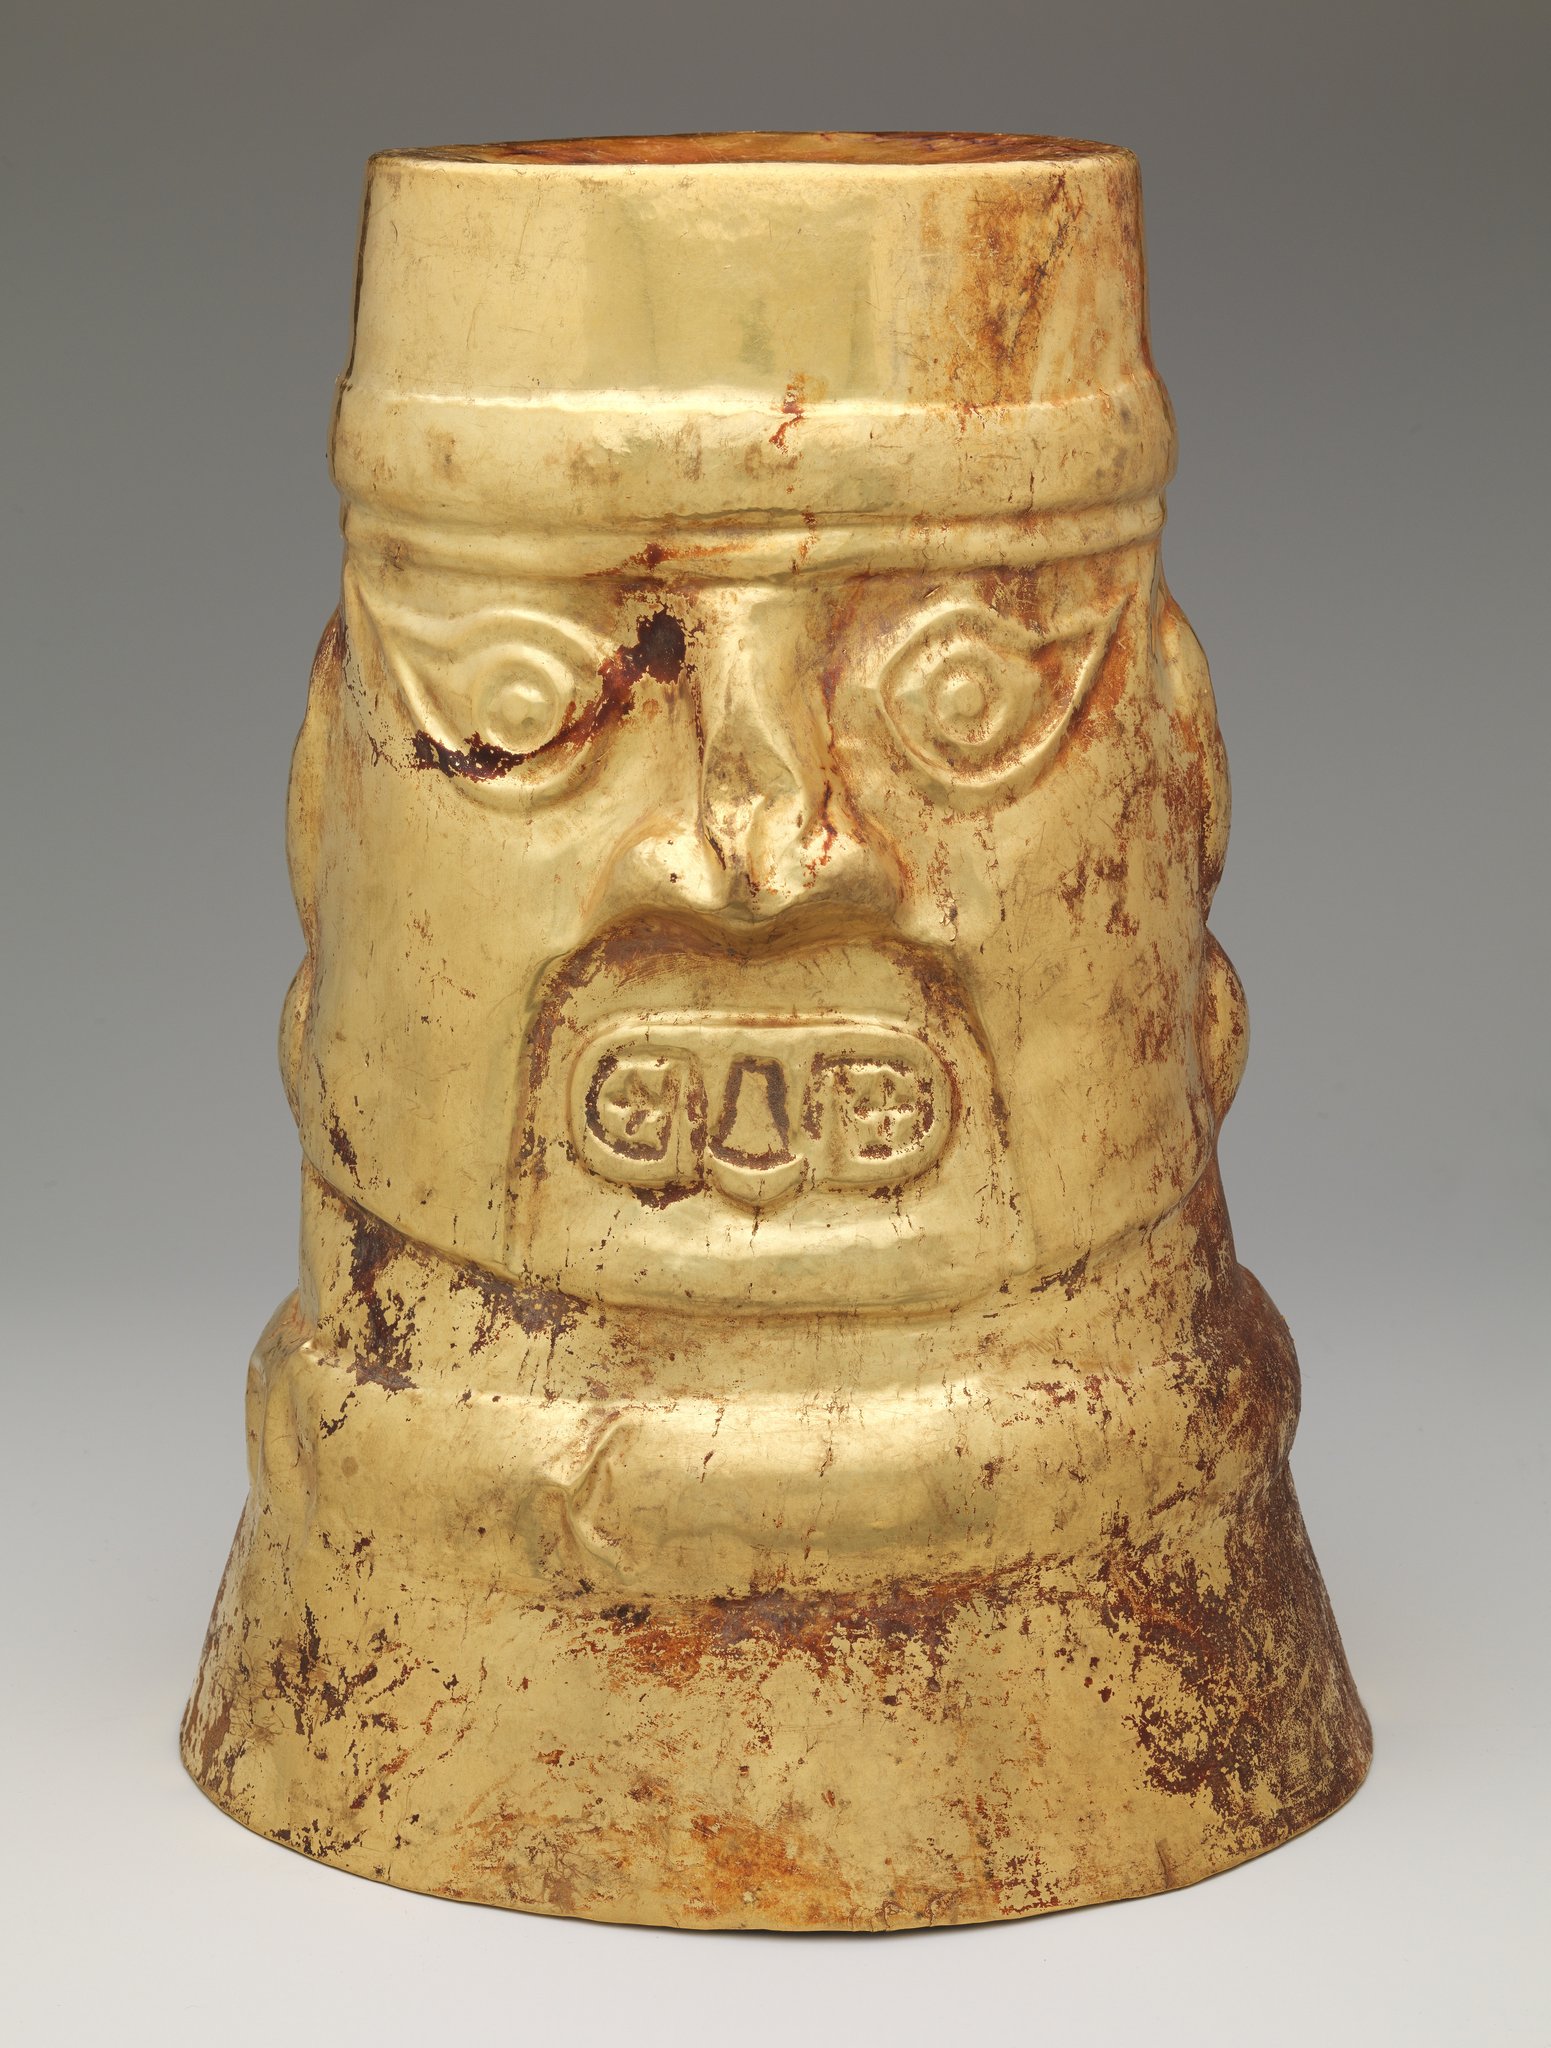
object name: beaker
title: Beaker with inverse face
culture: lambayeque, sicán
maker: lambayeque (sicán) artist(s)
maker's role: artist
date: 900-1100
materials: gold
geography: peru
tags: faces